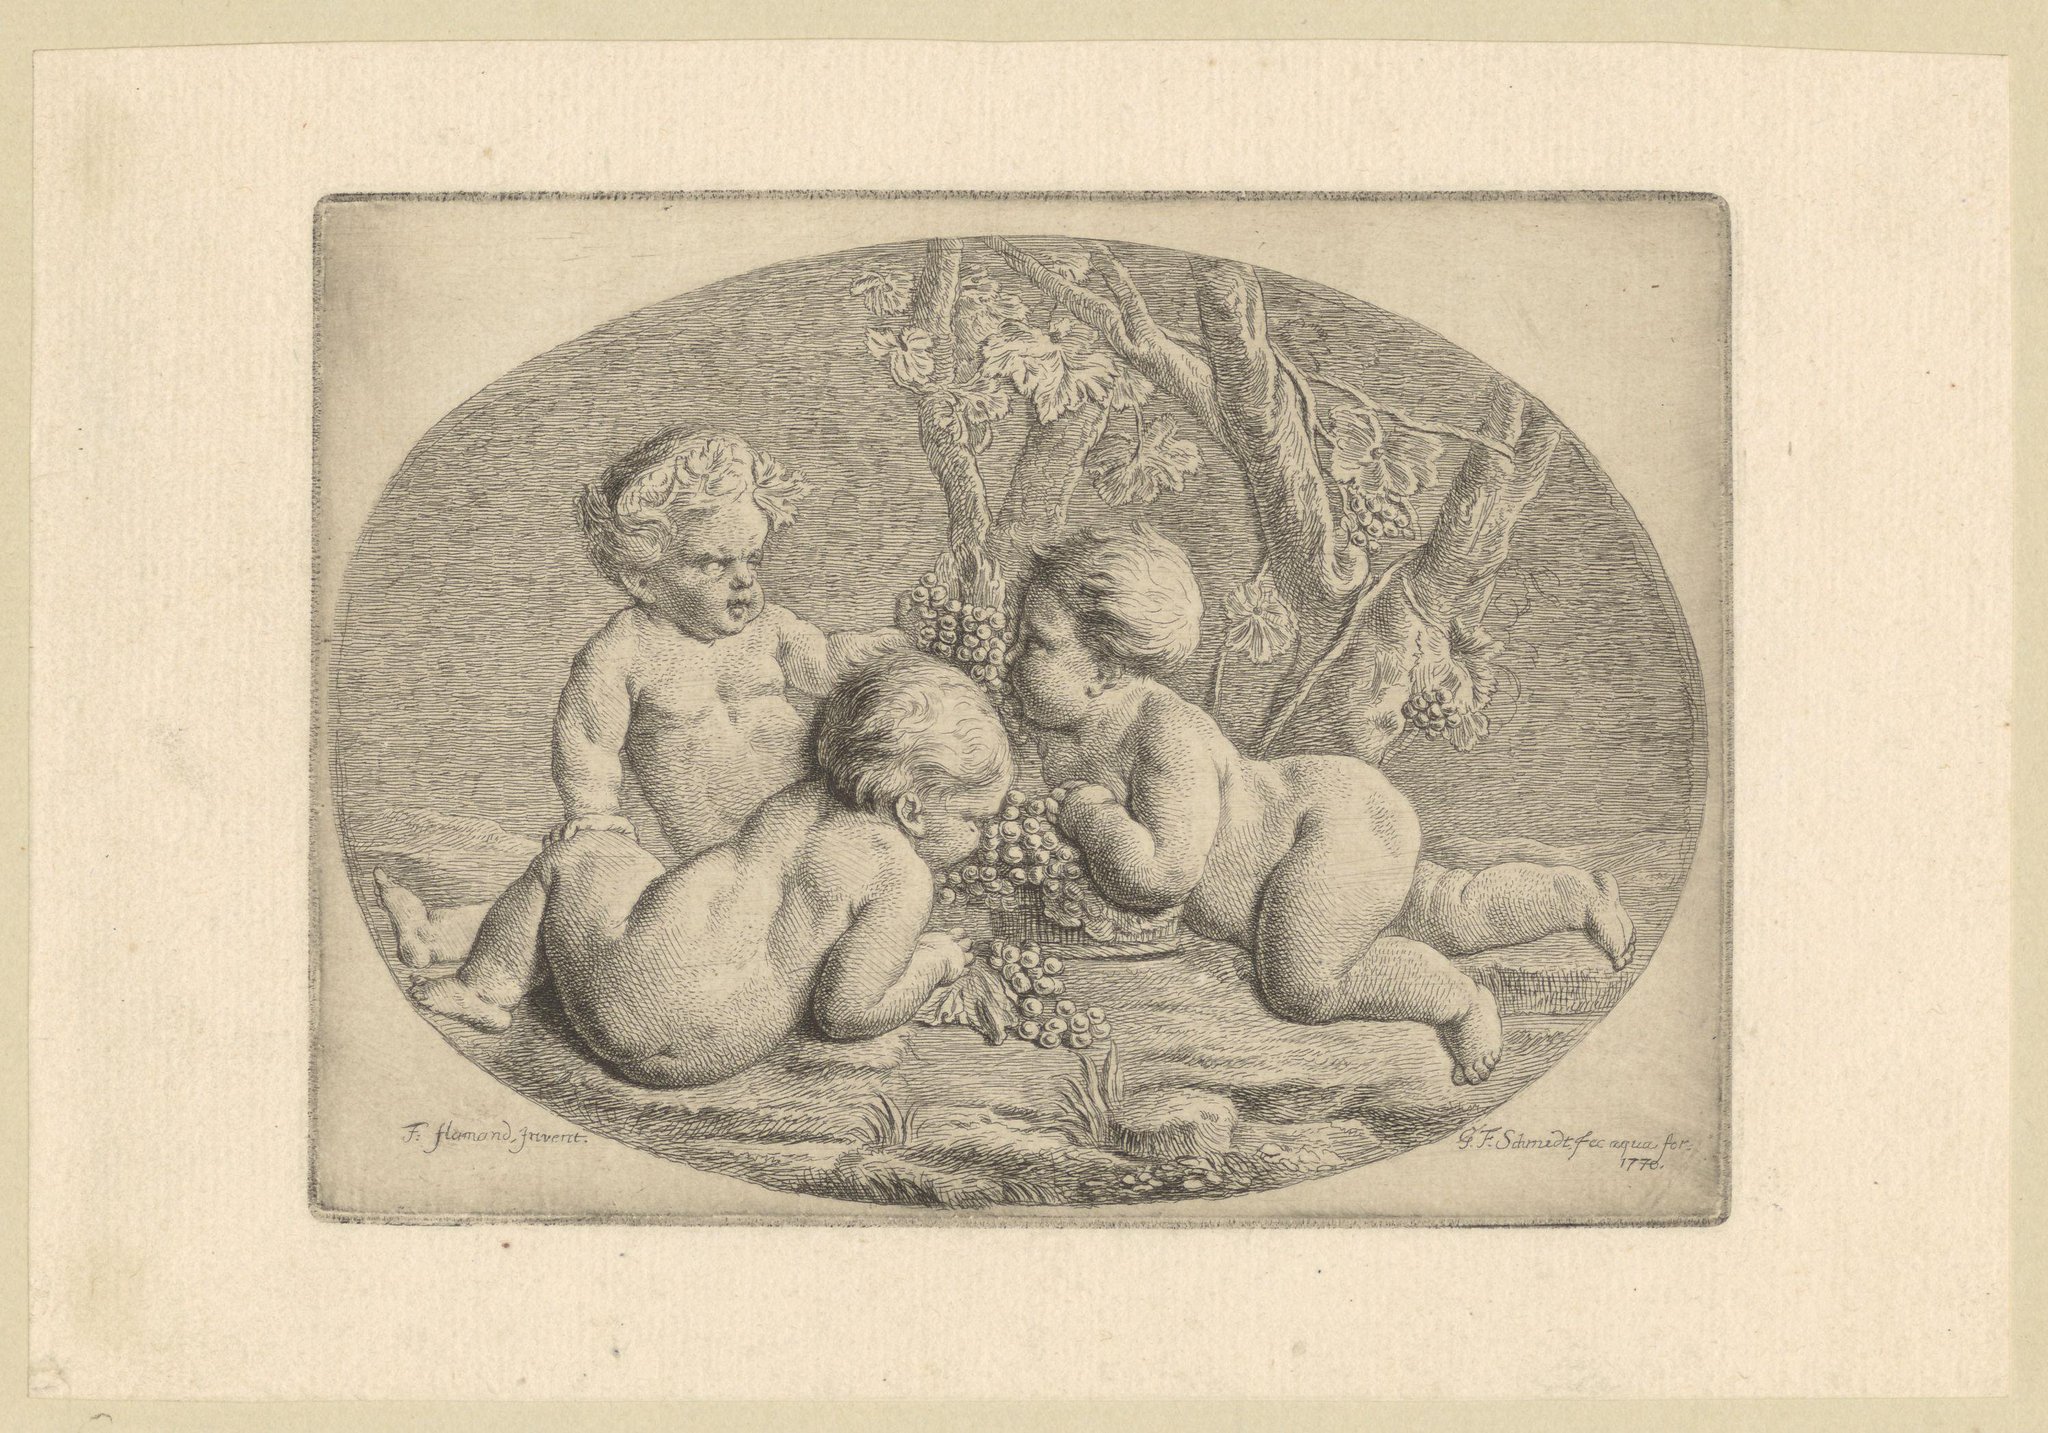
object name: print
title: Drie putti met druiventrossen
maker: georg friedrich schmidt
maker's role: draughtsman, print maker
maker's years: 1712-1775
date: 1770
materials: paper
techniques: etching, intaglio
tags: cupids: 'amores', 'amoretti', 'putti'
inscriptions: collector's mark: Lugt 240